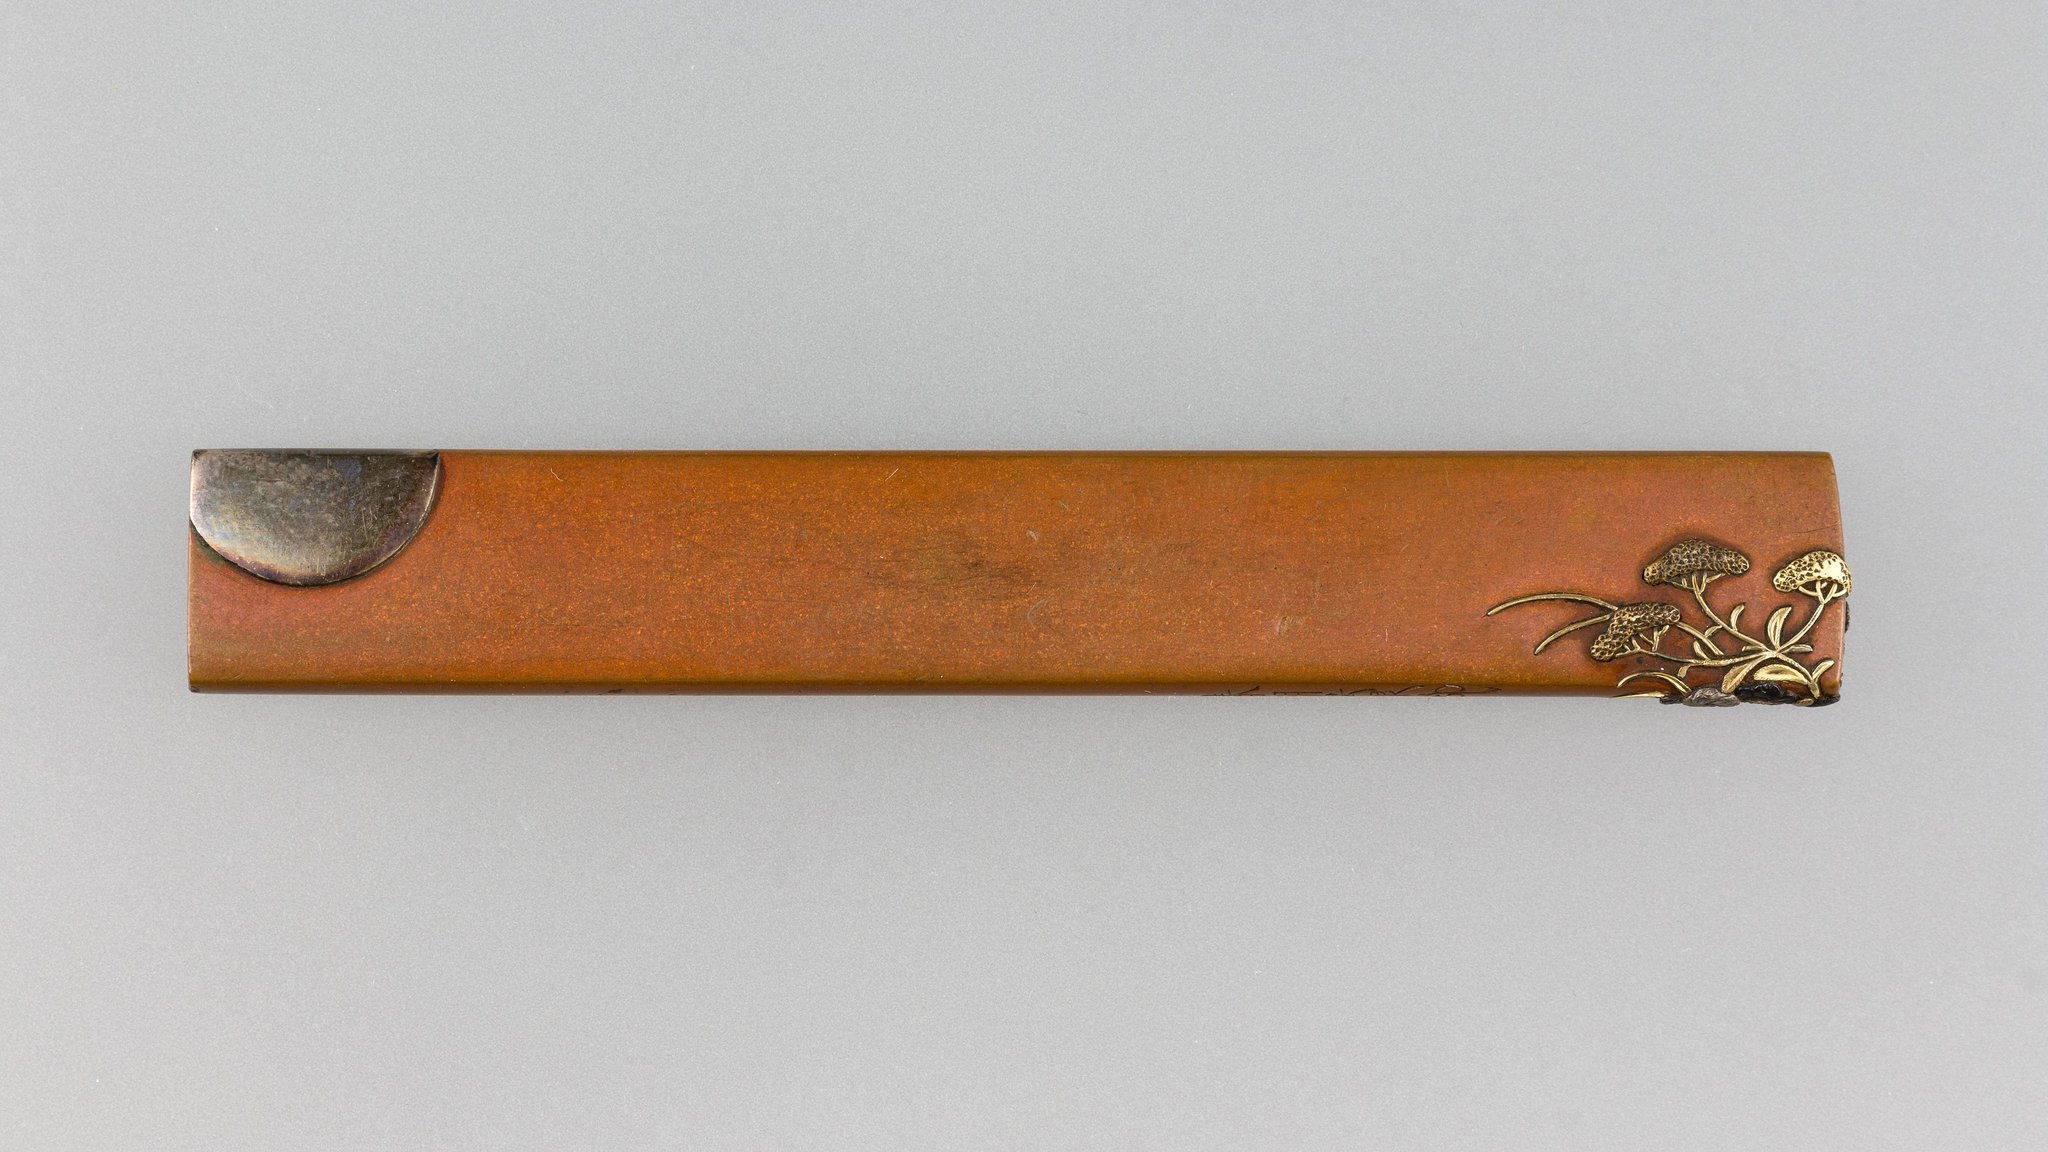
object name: knife handle kozuka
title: Knife Handle (Kozuka)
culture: japanese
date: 1801-1900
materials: copper, gold alloy, gold, silver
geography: japan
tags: flowers